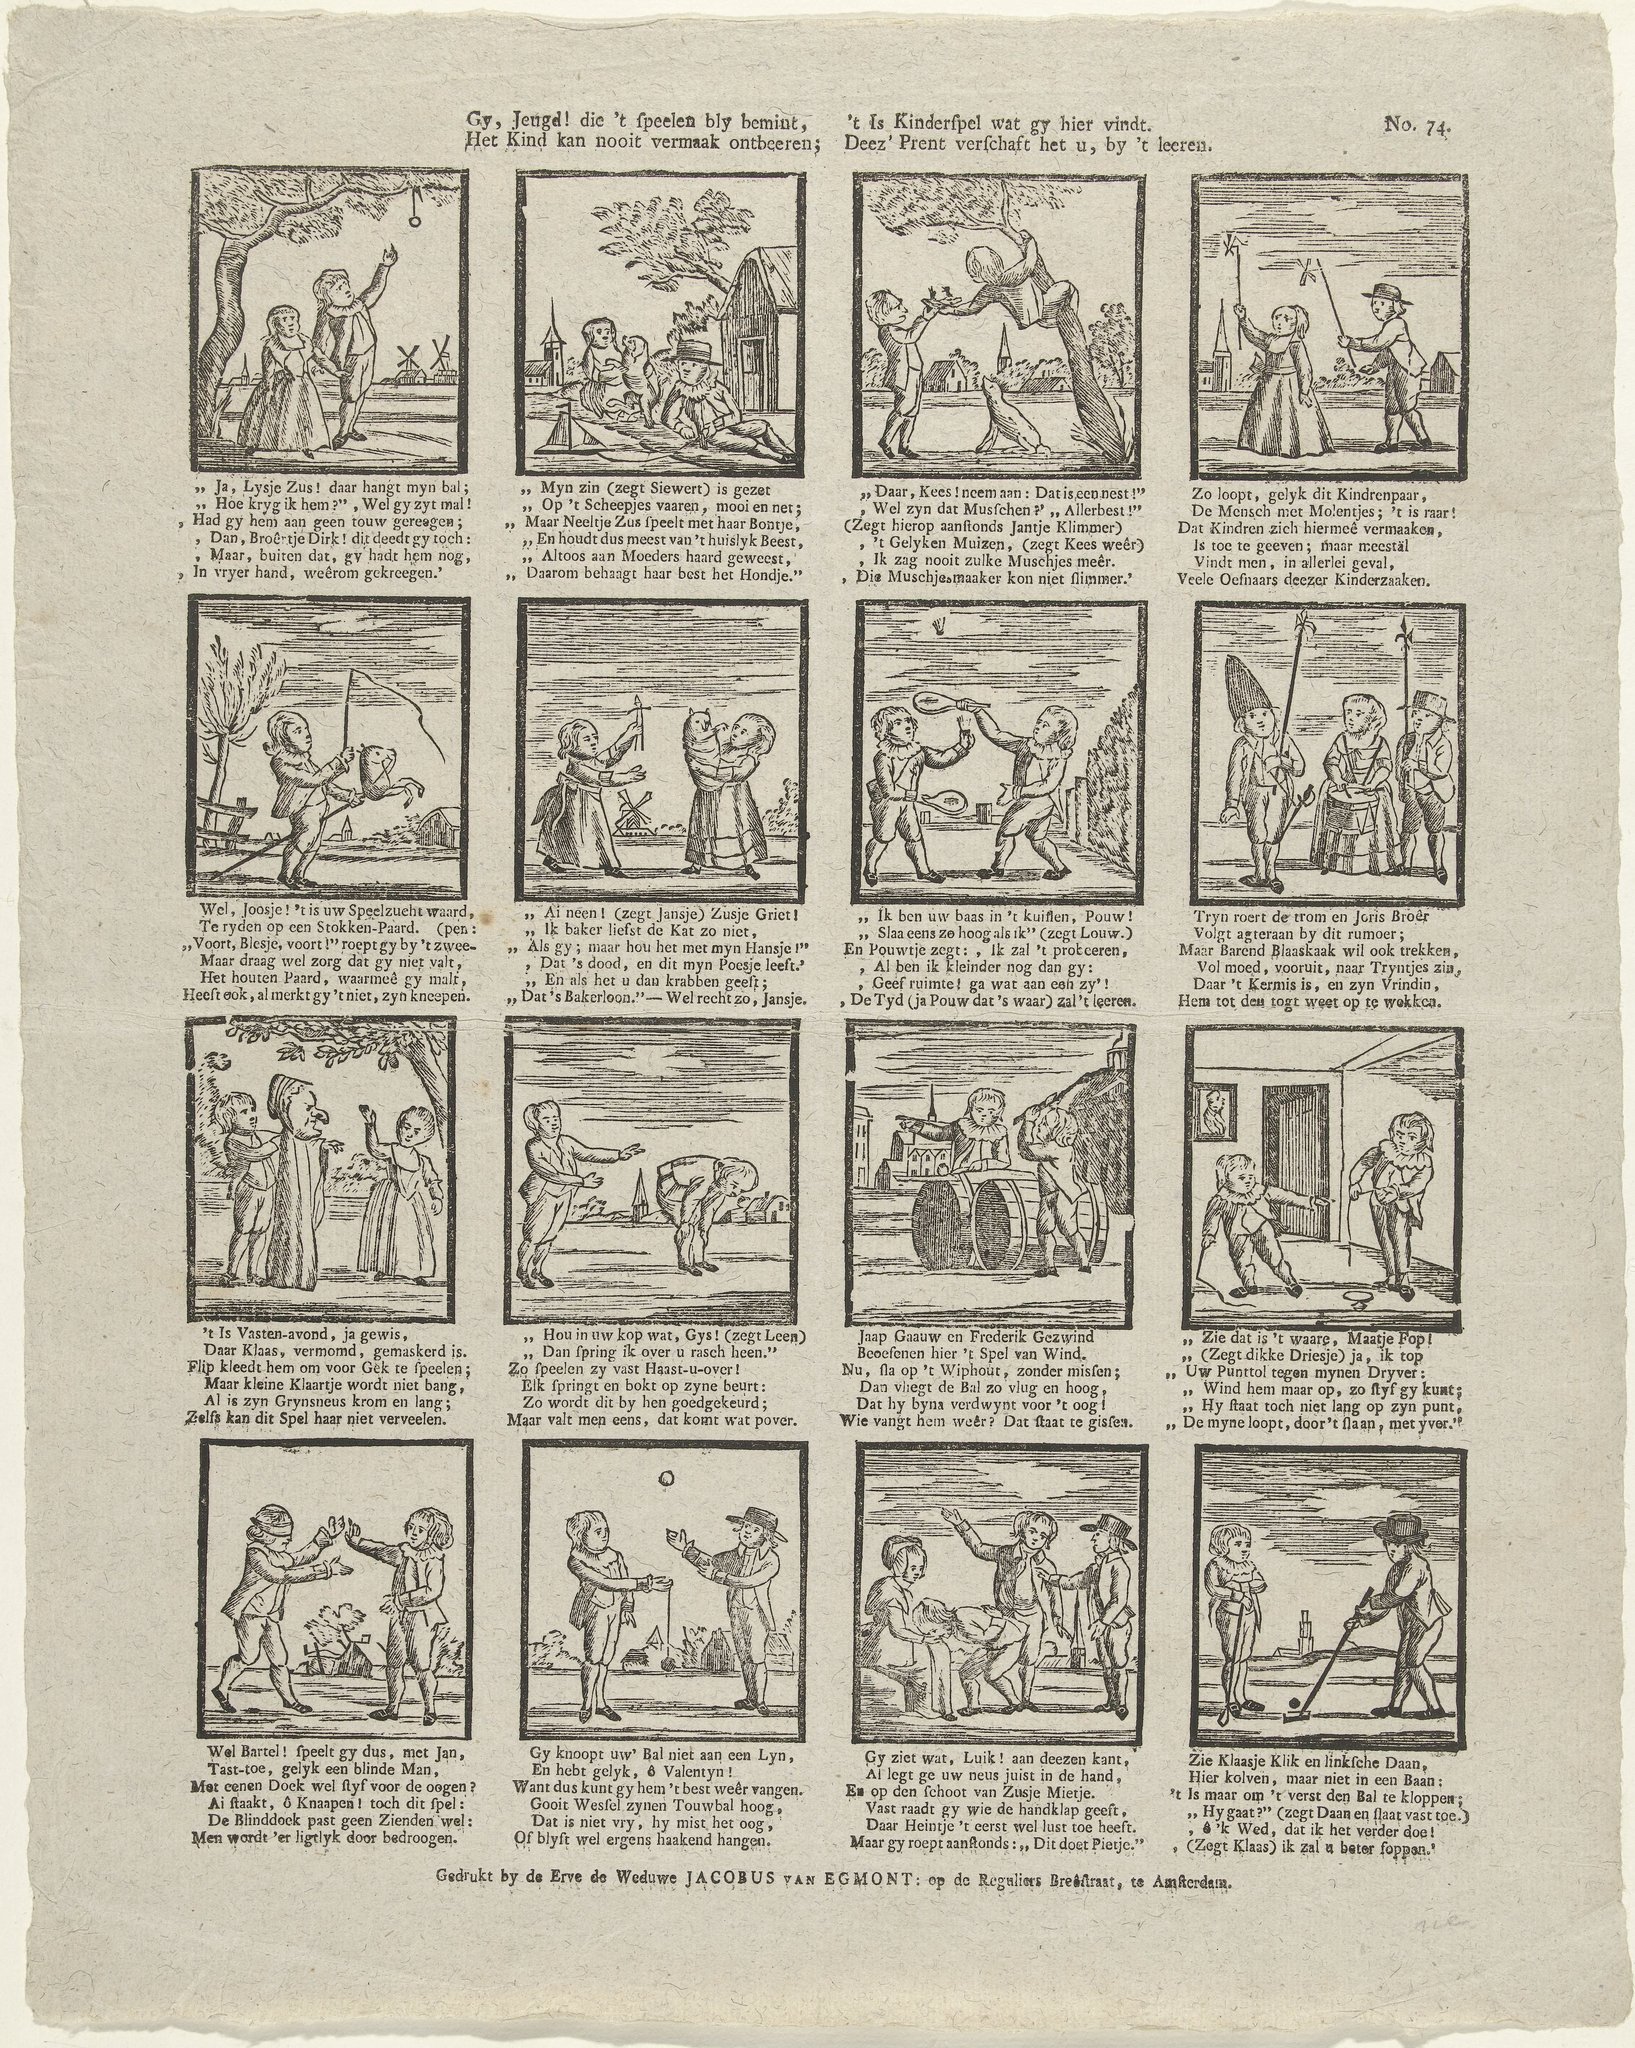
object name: popular print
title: Gy, jeugd! die 't speelen bly bemint, / Het kind kan nooit vermaak ontbeeren; / 't is kinderspel wat gy hier vindt. / Deez' prent verschaft het u, by het leeren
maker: Anonymous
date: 1761-1804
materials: paper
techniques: letterpress printing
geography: amsterdam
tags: children's games and plays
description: Blad met 16 voorstellingen van kinderspelen, waaronder stokpaardjerijden, met de poes spelen en tollen. Onder elke afbeelding een zesregelig vers. Genummerd rechtsboven: No. 74.